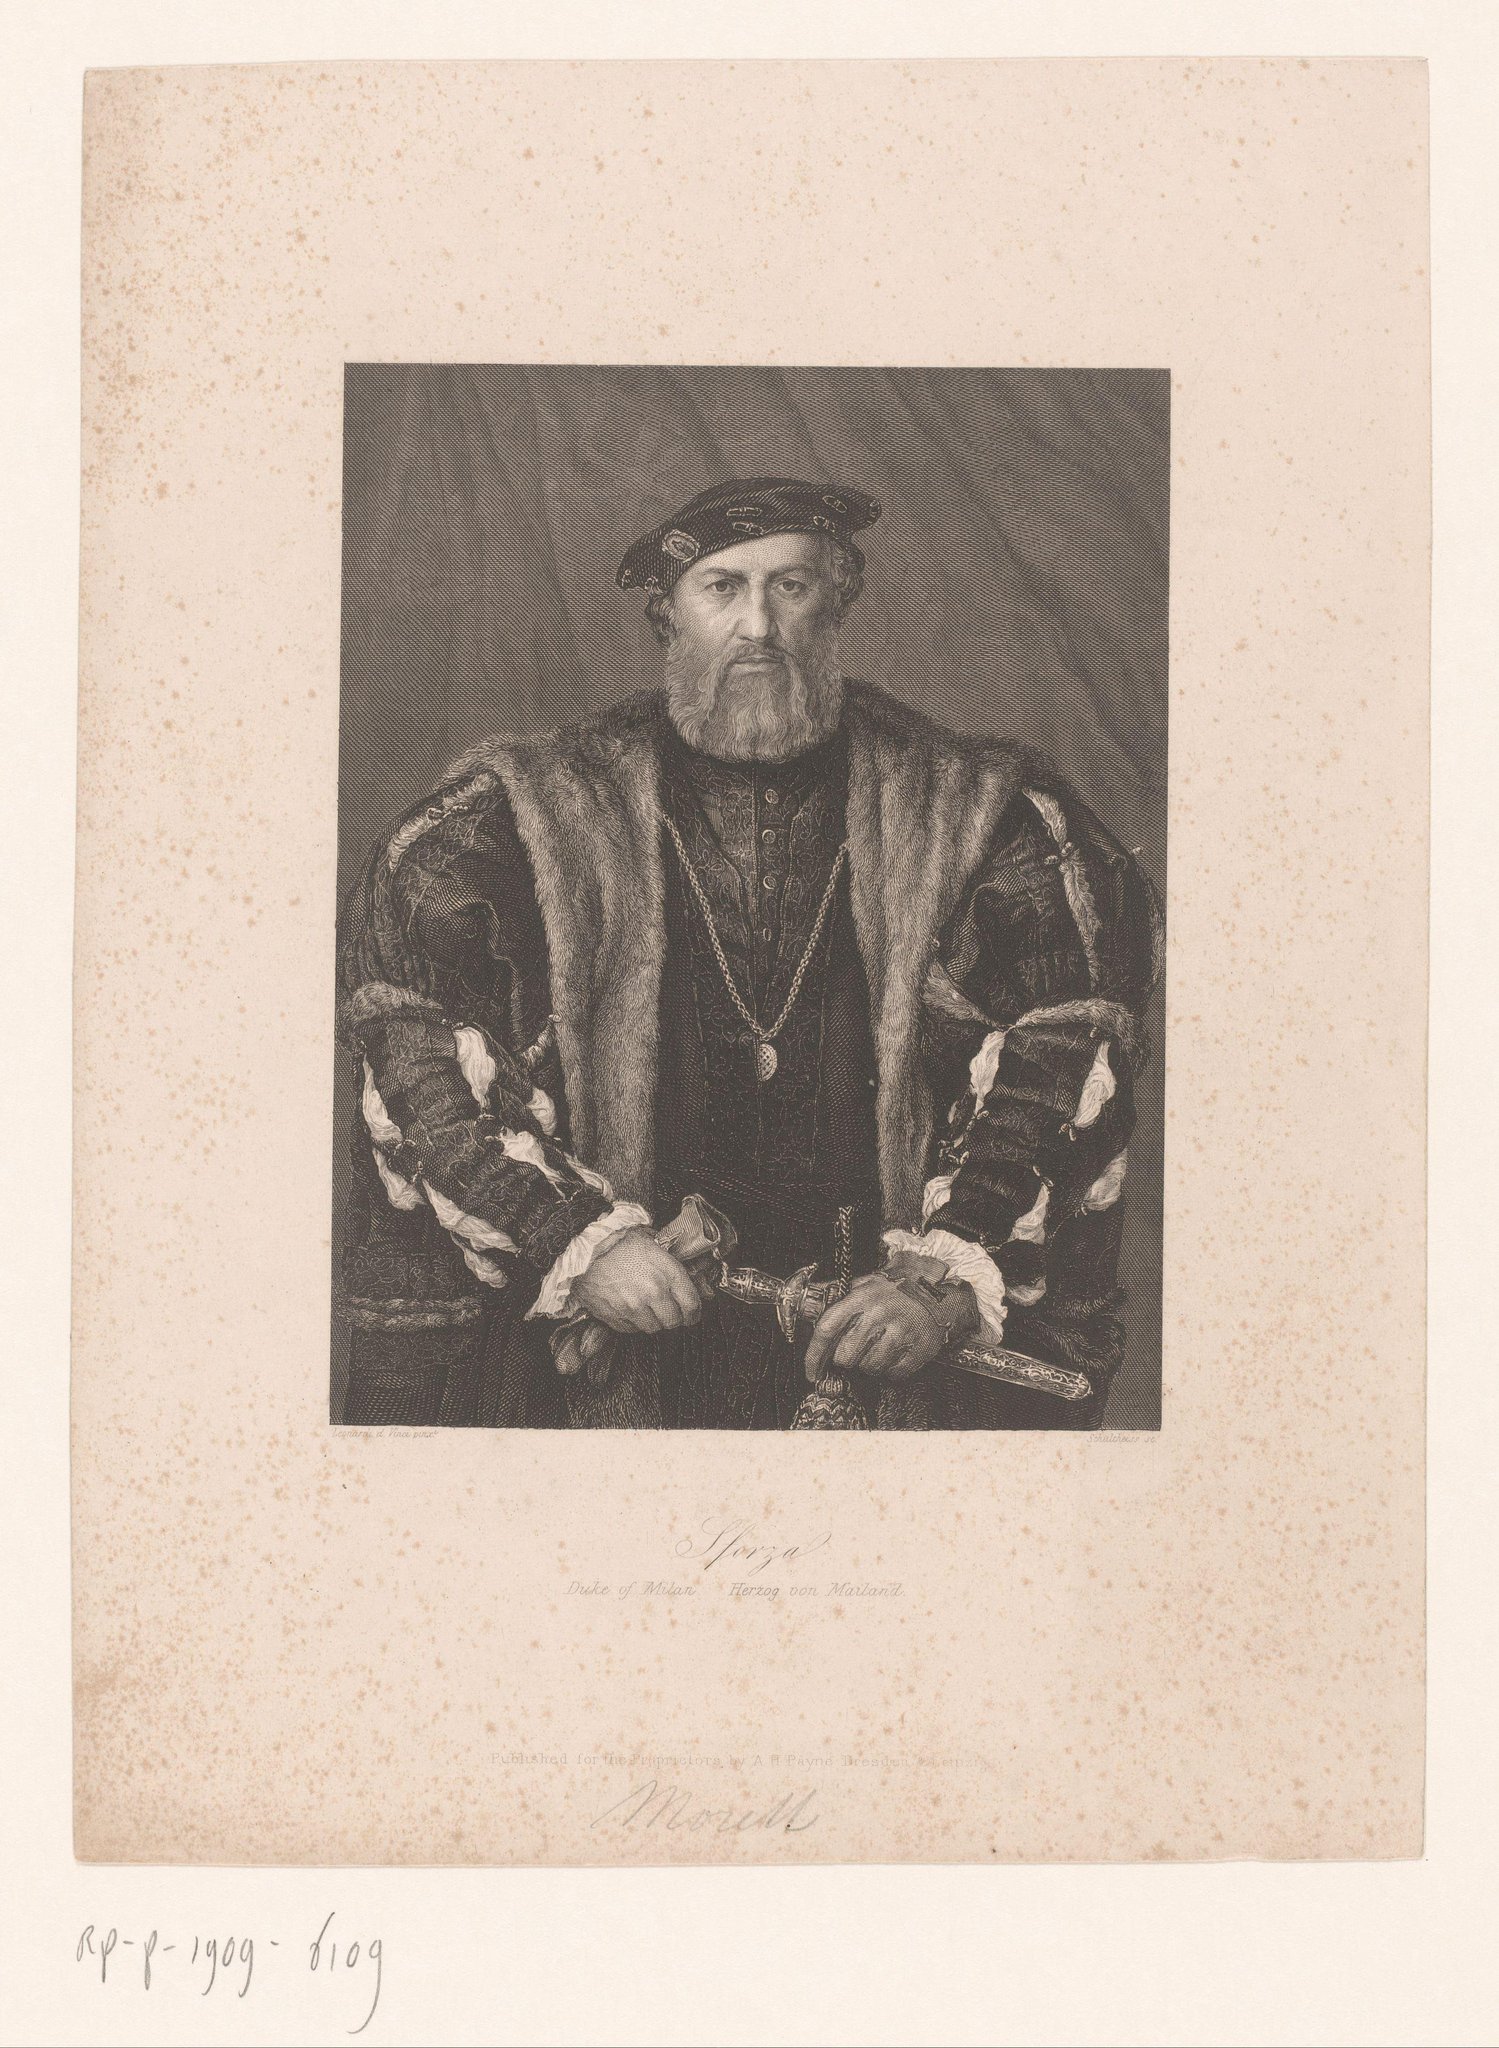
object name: print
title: Portret van Charles de Solier, comte de Morrette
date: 1833-1909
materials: paper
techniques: engraving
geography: leipzig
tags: historical persons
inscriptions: collector's mark: Lugt 2228